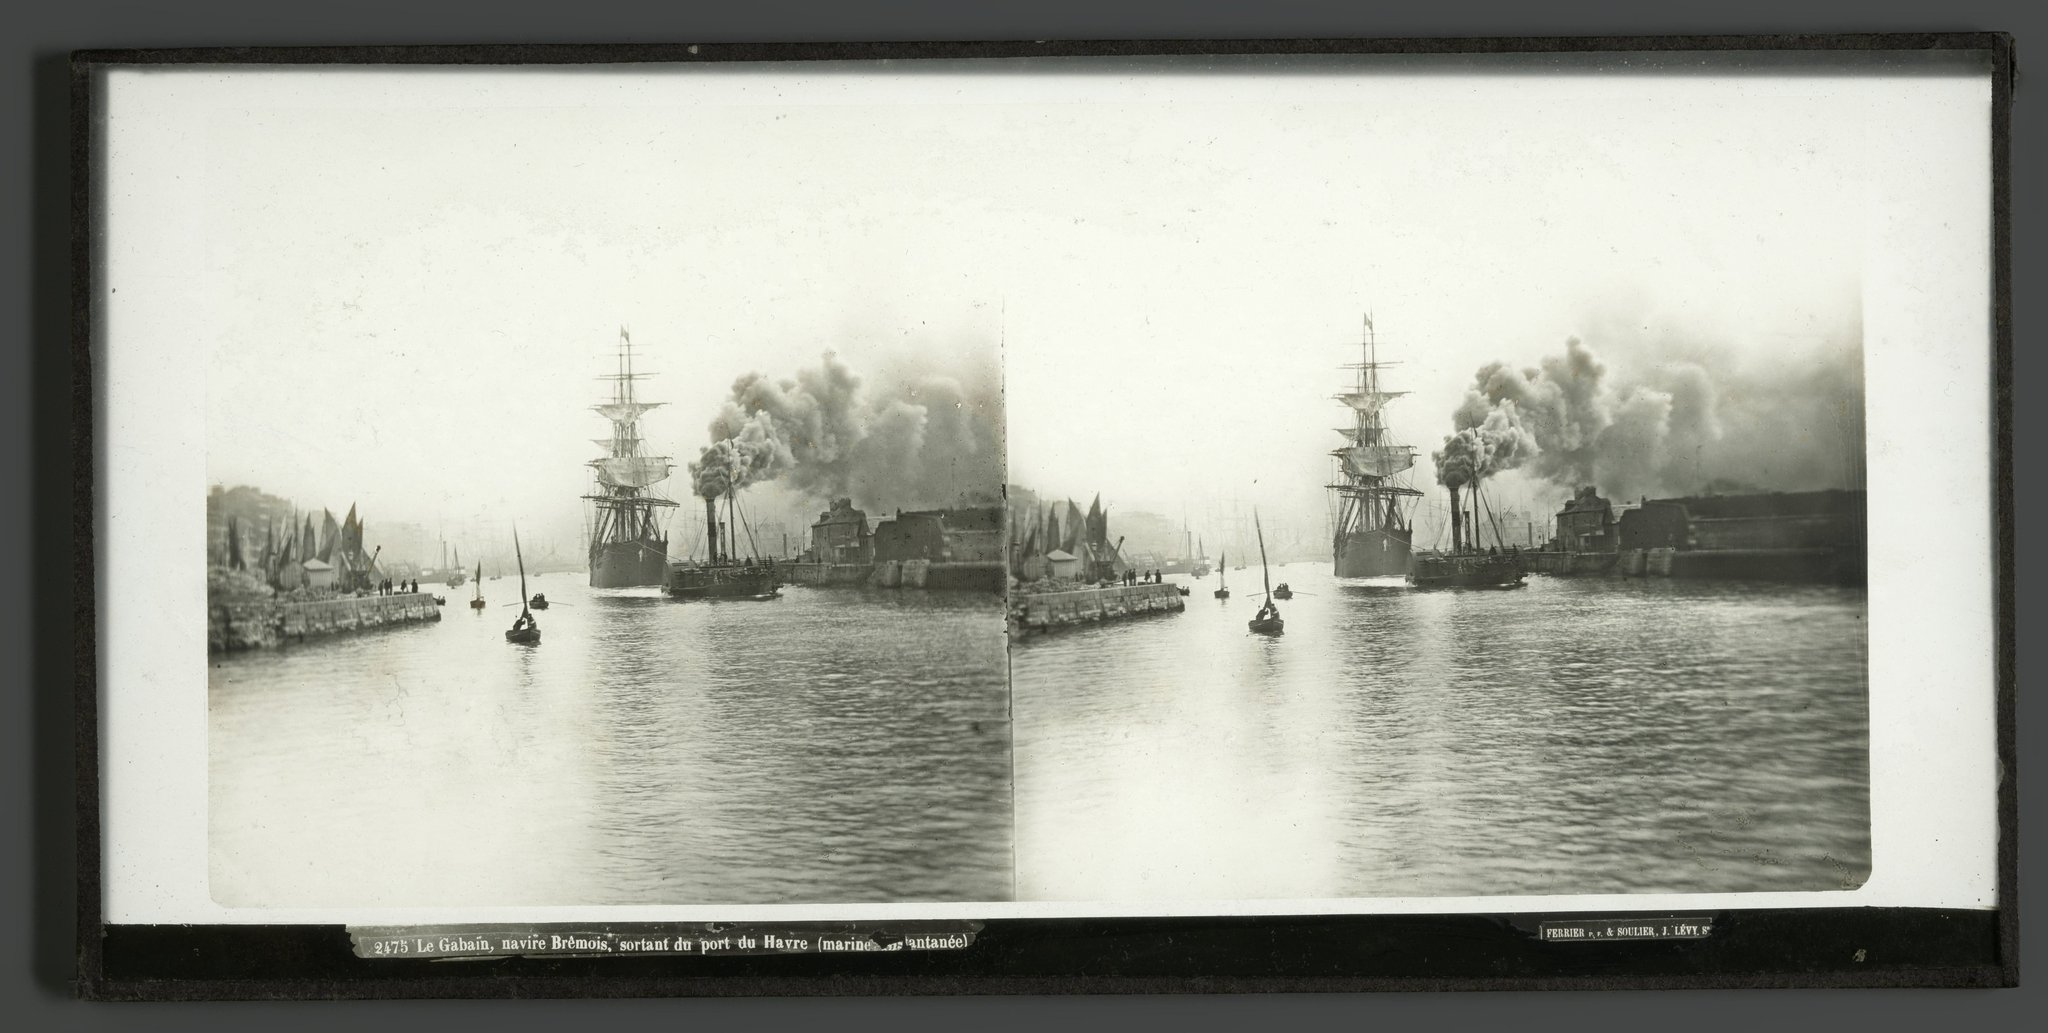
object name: photograph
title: Le Gabaïn navire Brémois, sortant du port du Havre (marine instantanée)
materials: glass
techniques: photography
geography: le havre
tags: harbour, le havre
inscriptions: : ‘2475 Le Gabaïn navire Brémois, sortant du port du Havre (marine instantanée).’